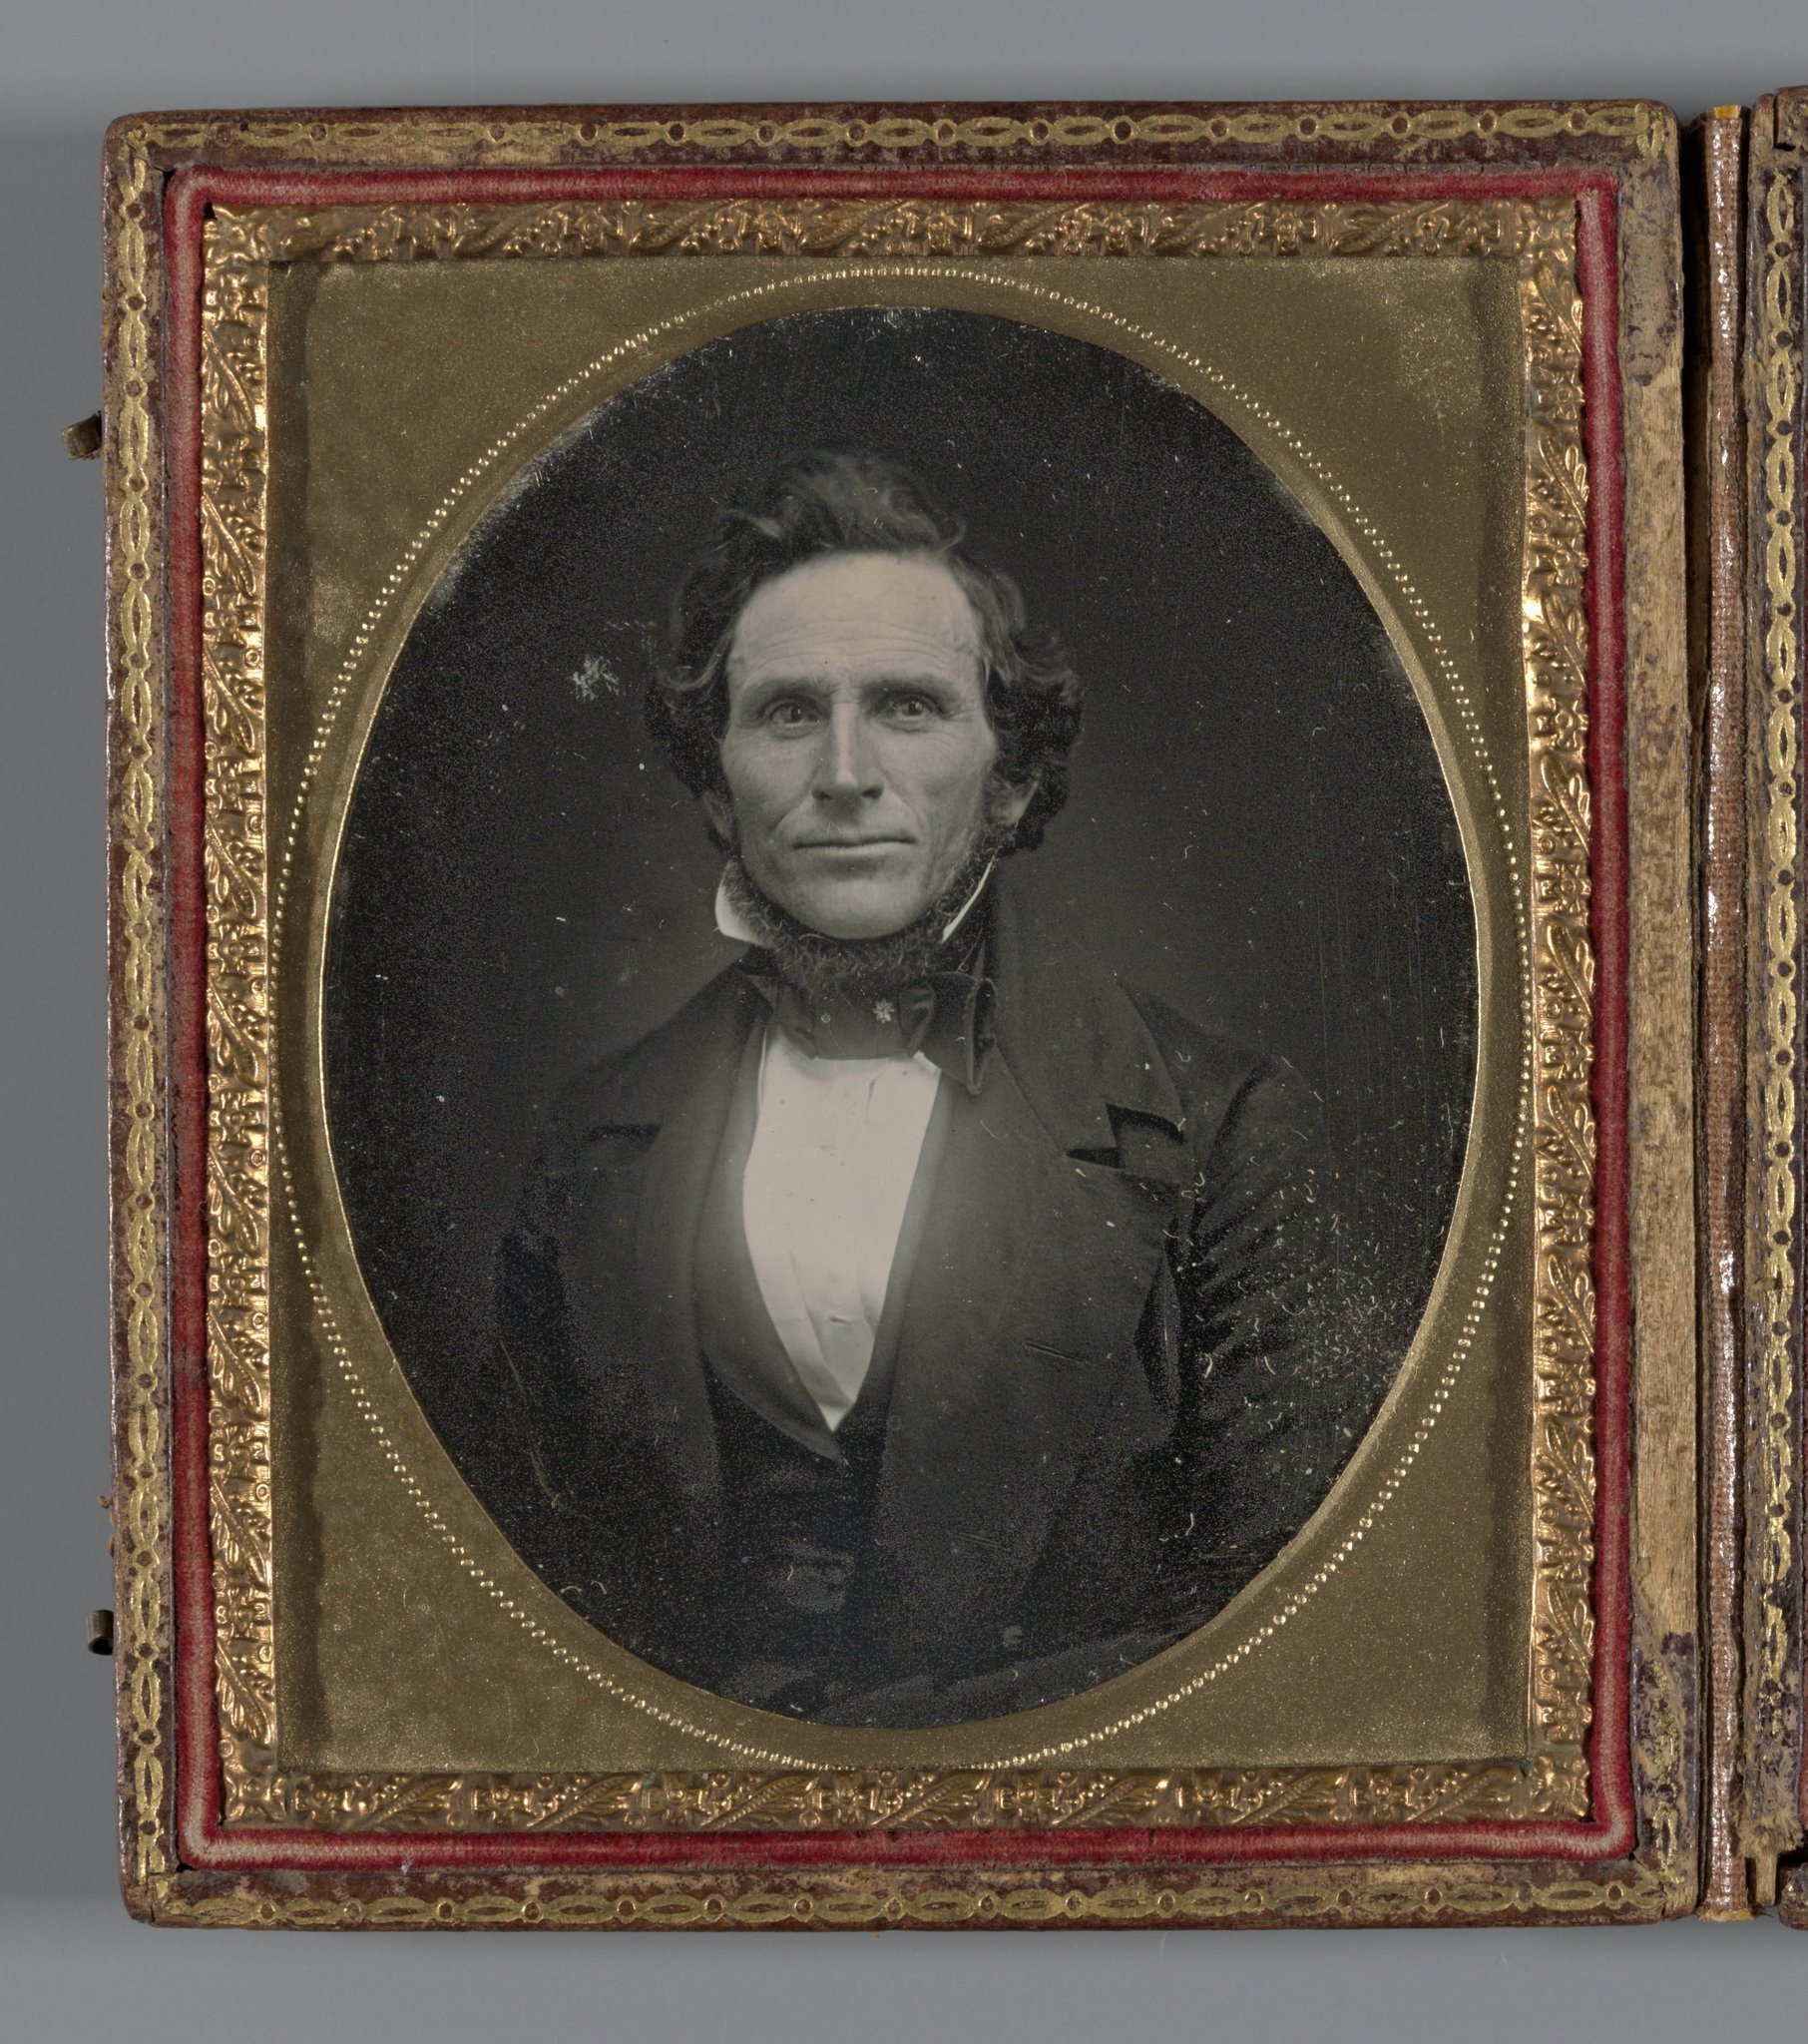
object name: photograph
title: Portret van een onbekende man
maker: Anonymous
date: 1857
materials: copper, glass, leather, velvet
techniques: daguerreotype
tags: adult man, historical persons